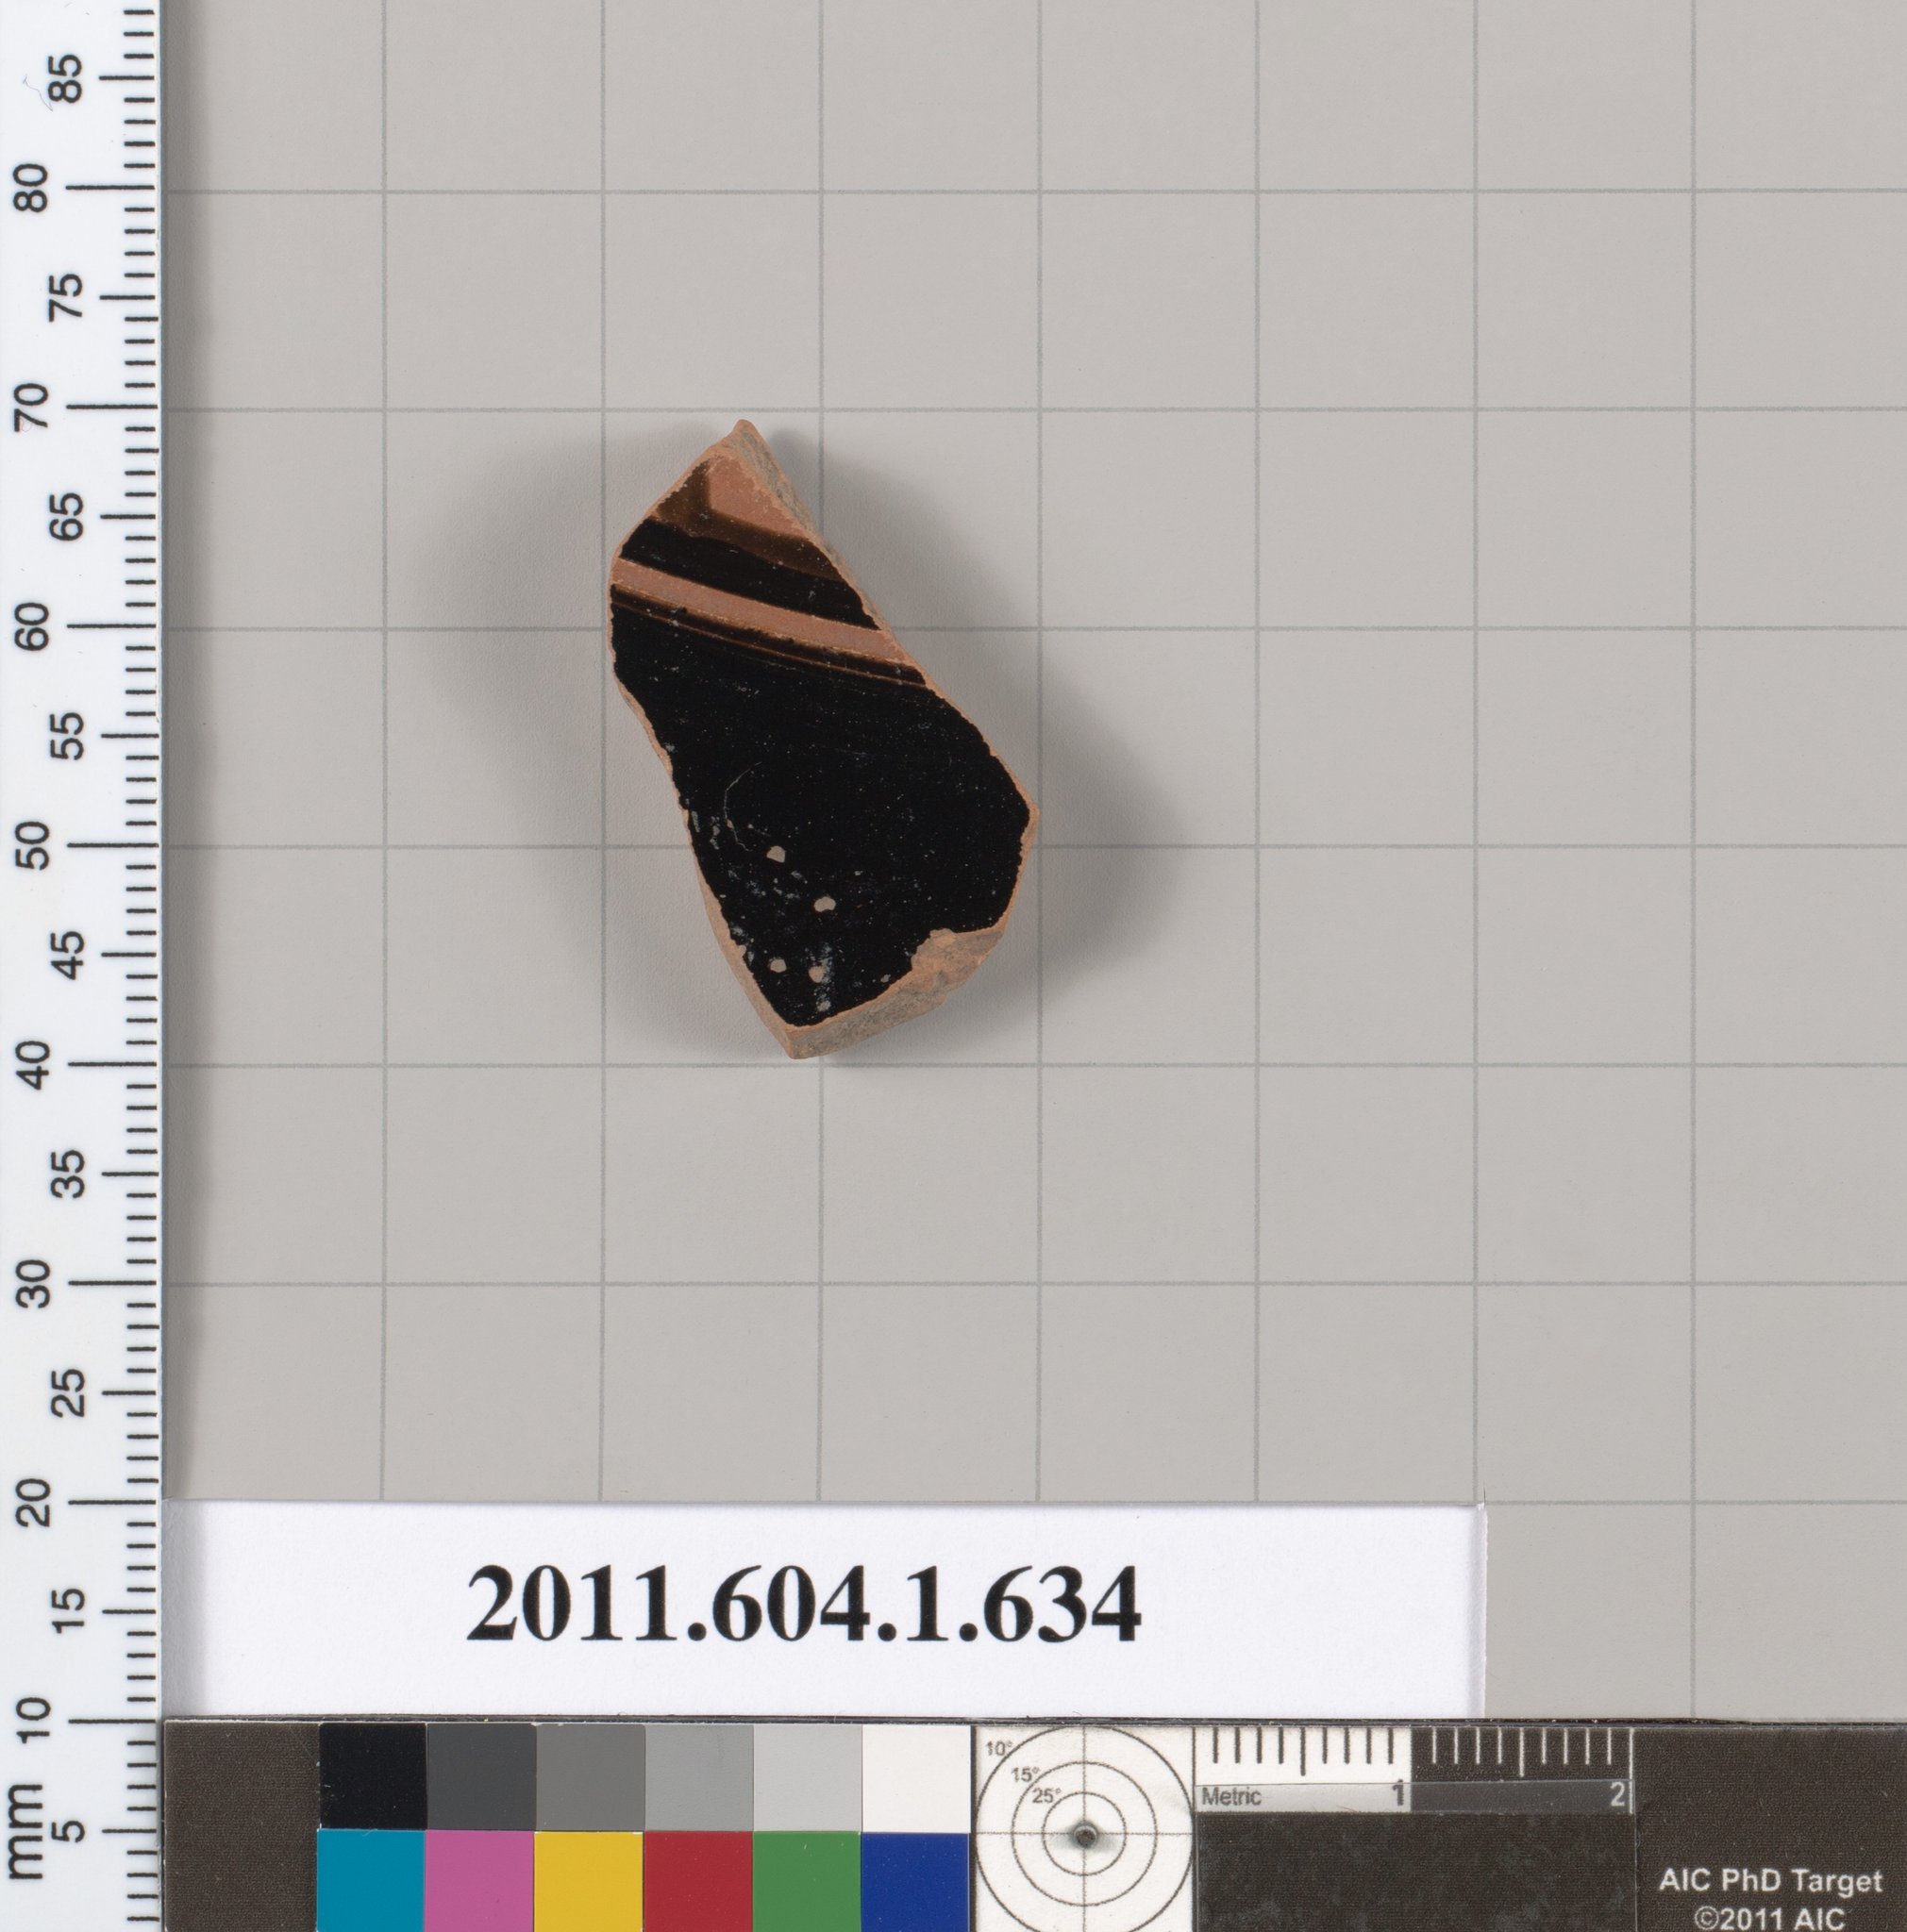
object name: kylix fragment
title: Terracotta fragment of a kylix (drinking cup)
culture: greek, attic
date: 450-401 BCE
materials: terracotta